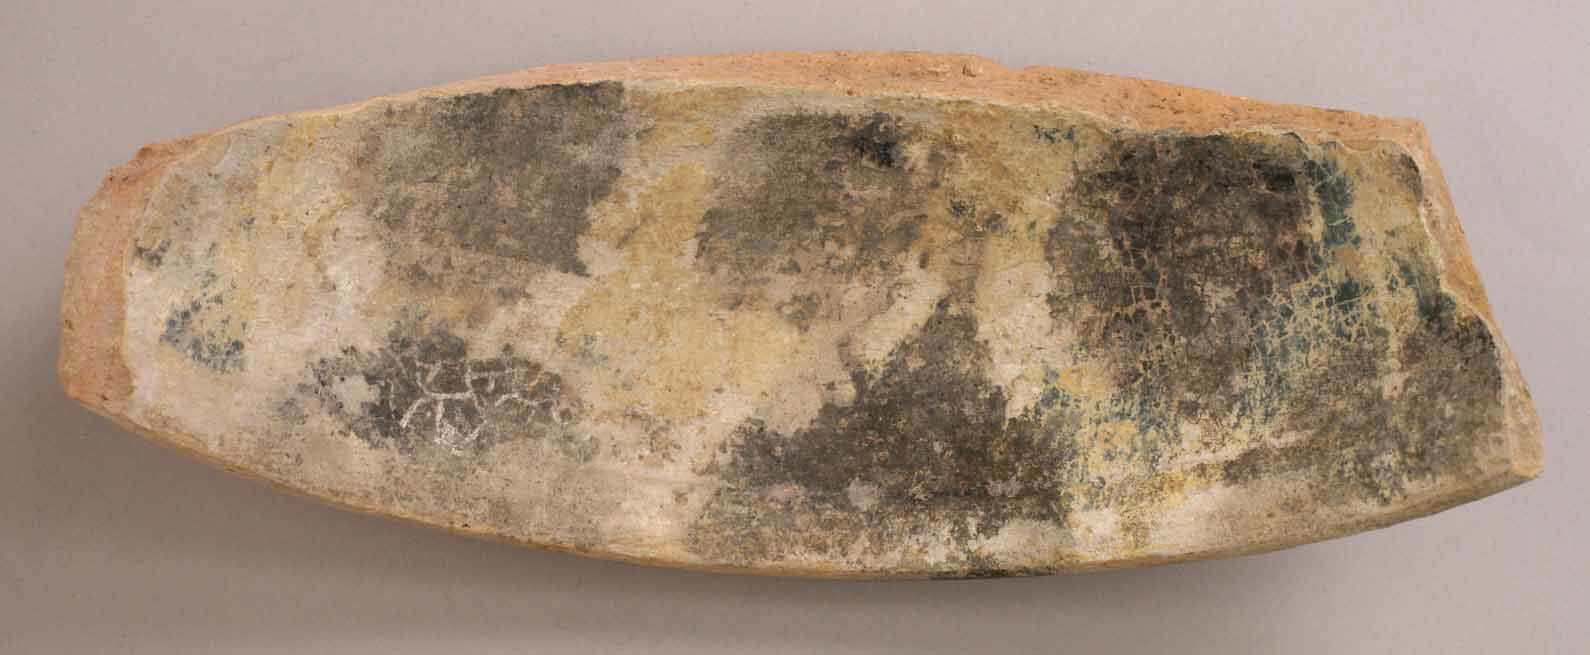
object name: fragment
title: Ceramic Fragment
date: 701-900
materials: earthenware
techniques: glazing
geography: iraq